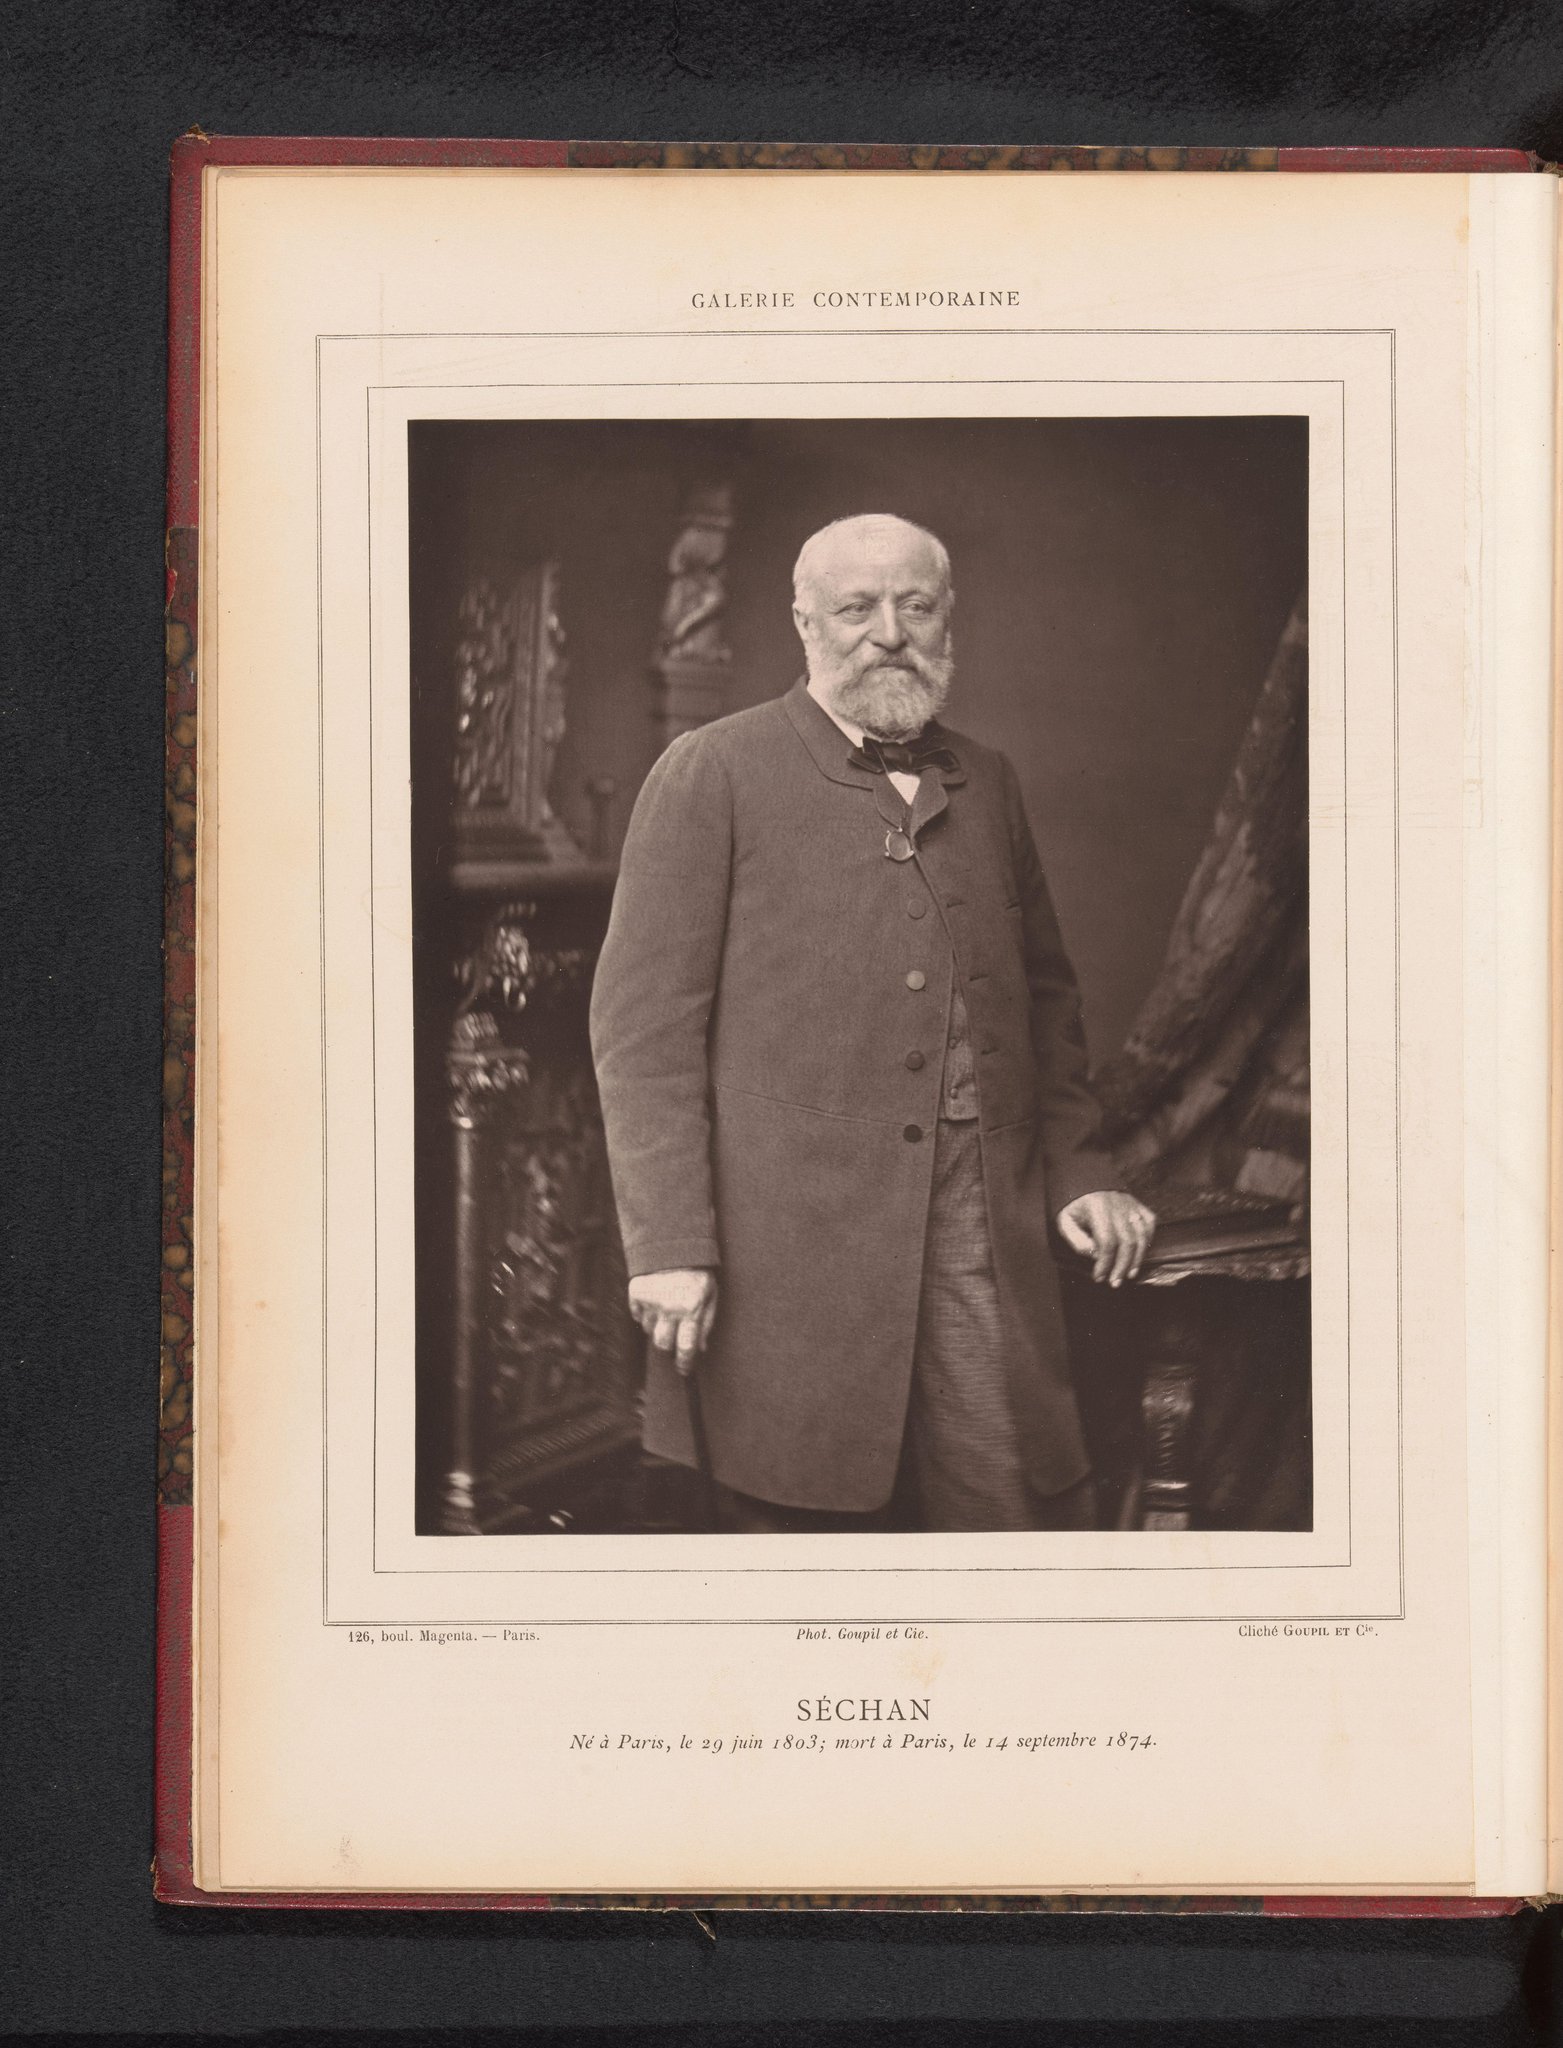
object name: page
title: Portret van Charles Séchan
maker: Anonymous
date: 1875-1880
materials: paper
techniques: woodburytype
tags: paris, draughtsman, adult man, historical persons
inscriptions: inscription: ‘Galerie Contemporaine/ 126, boul. Magenta. - Paris./ Né a Paris, le 29 juin 1803; mort a Paris, le 14 septembre 1874.’